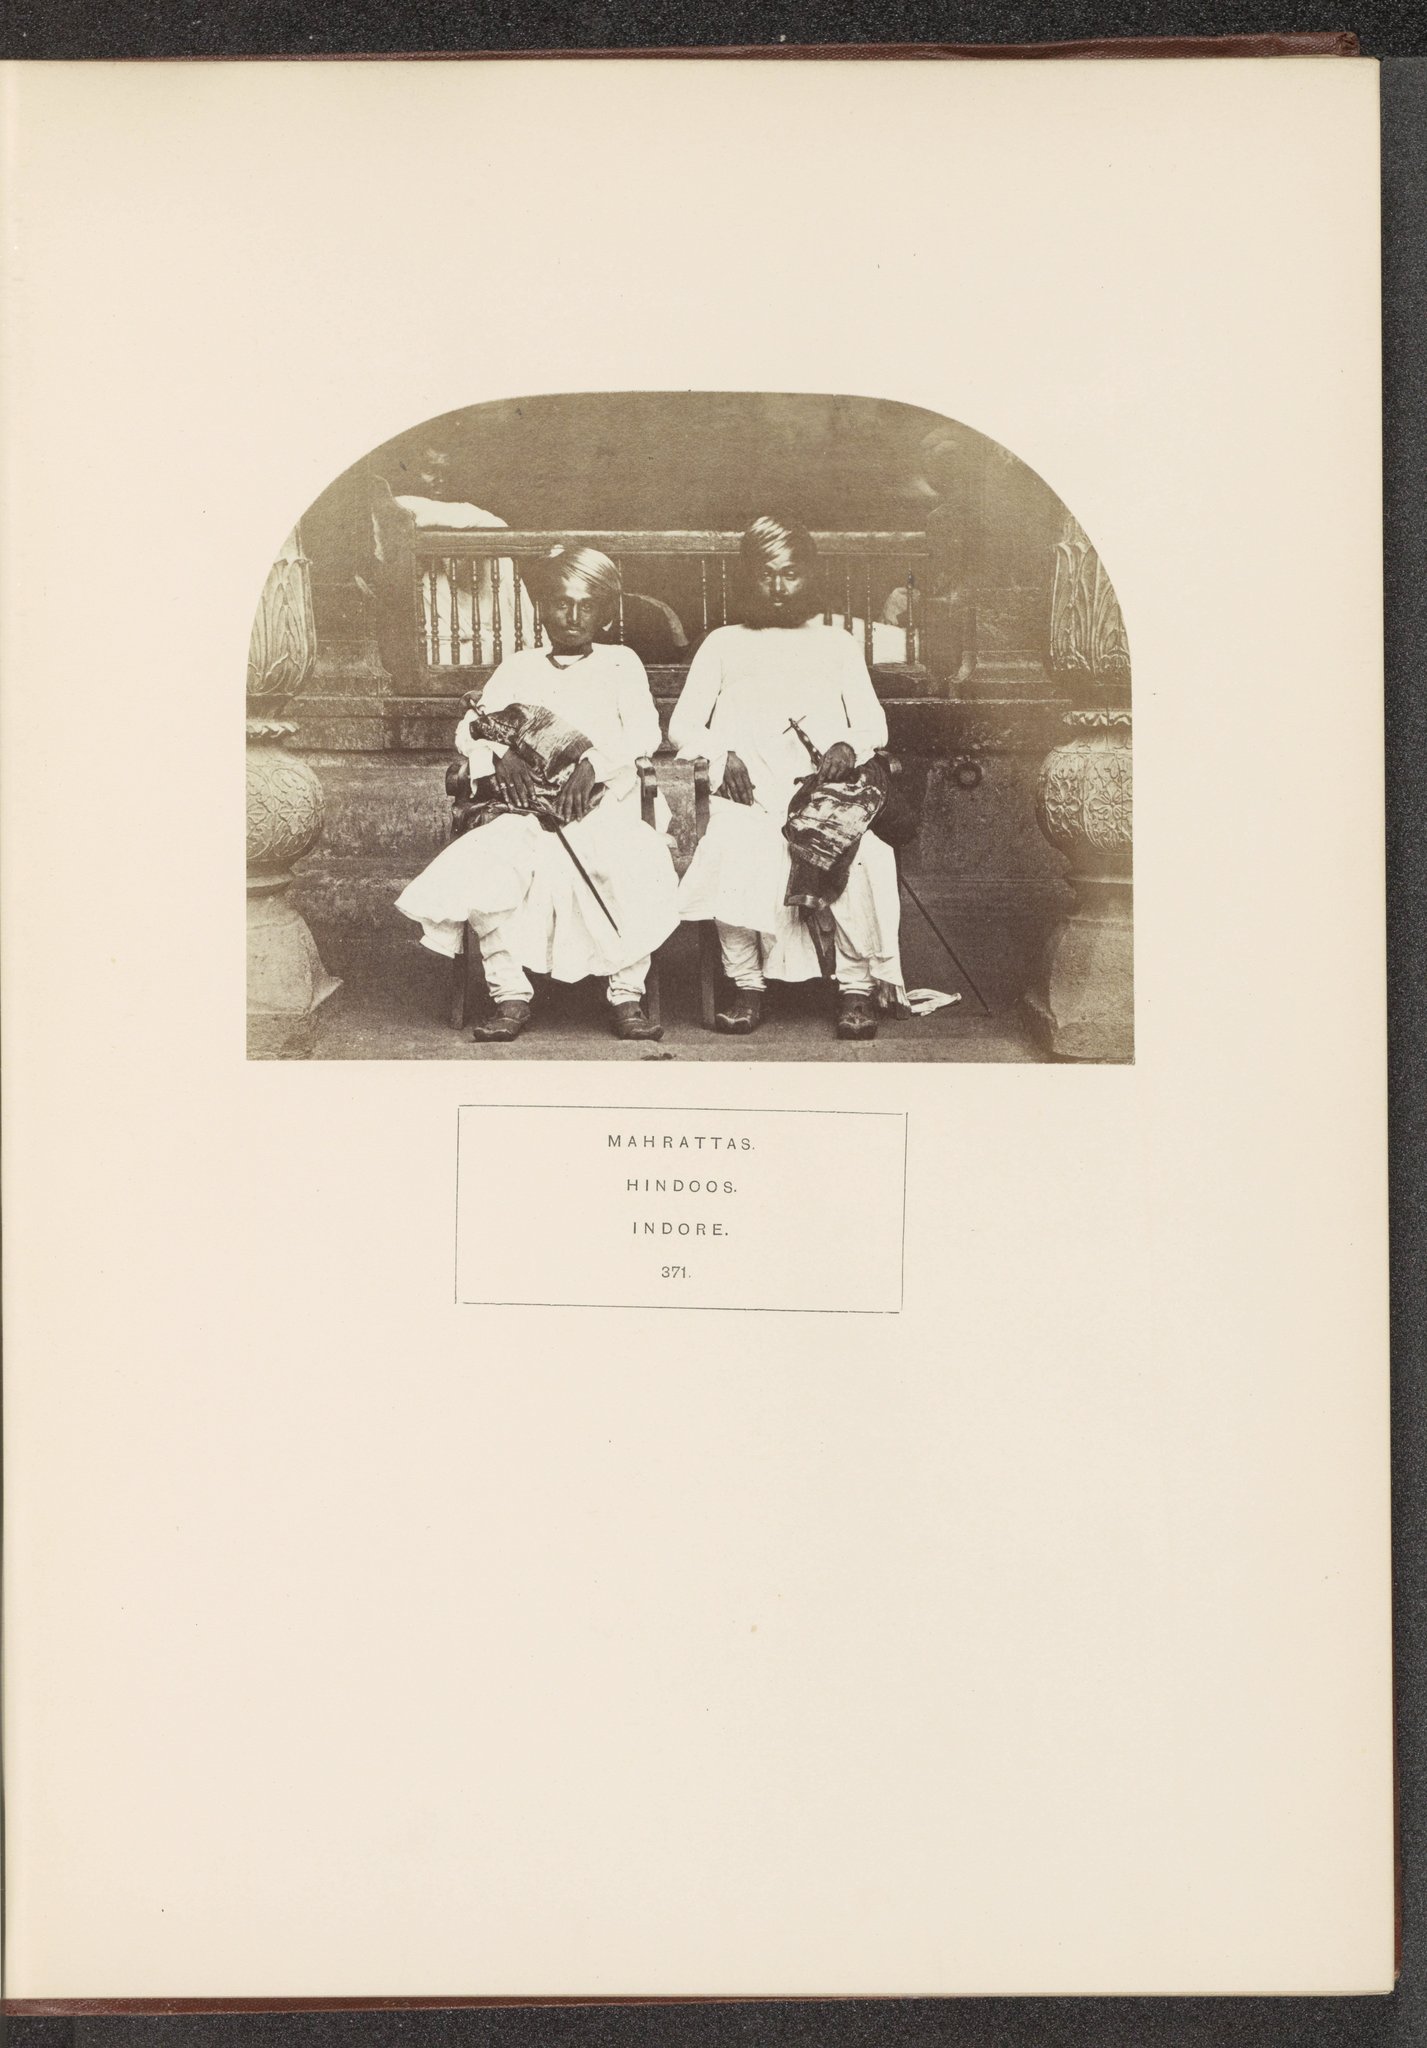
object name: photograph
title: Portrait of two unknown men from the Maratha community in the Holkar palace of Indore, Madhya Pradesh, India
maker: james john waterhouse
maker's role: fotograaf, luitenant, officier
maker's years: 1842-1928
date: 1862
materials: photographic support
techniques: albumen print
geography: indore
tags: head-gear: turban, human races; peoples; nationalities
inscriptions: number: ‘371.’, inscription: ‘MAHRATTAS./ HINDOOS./ INDORE.’